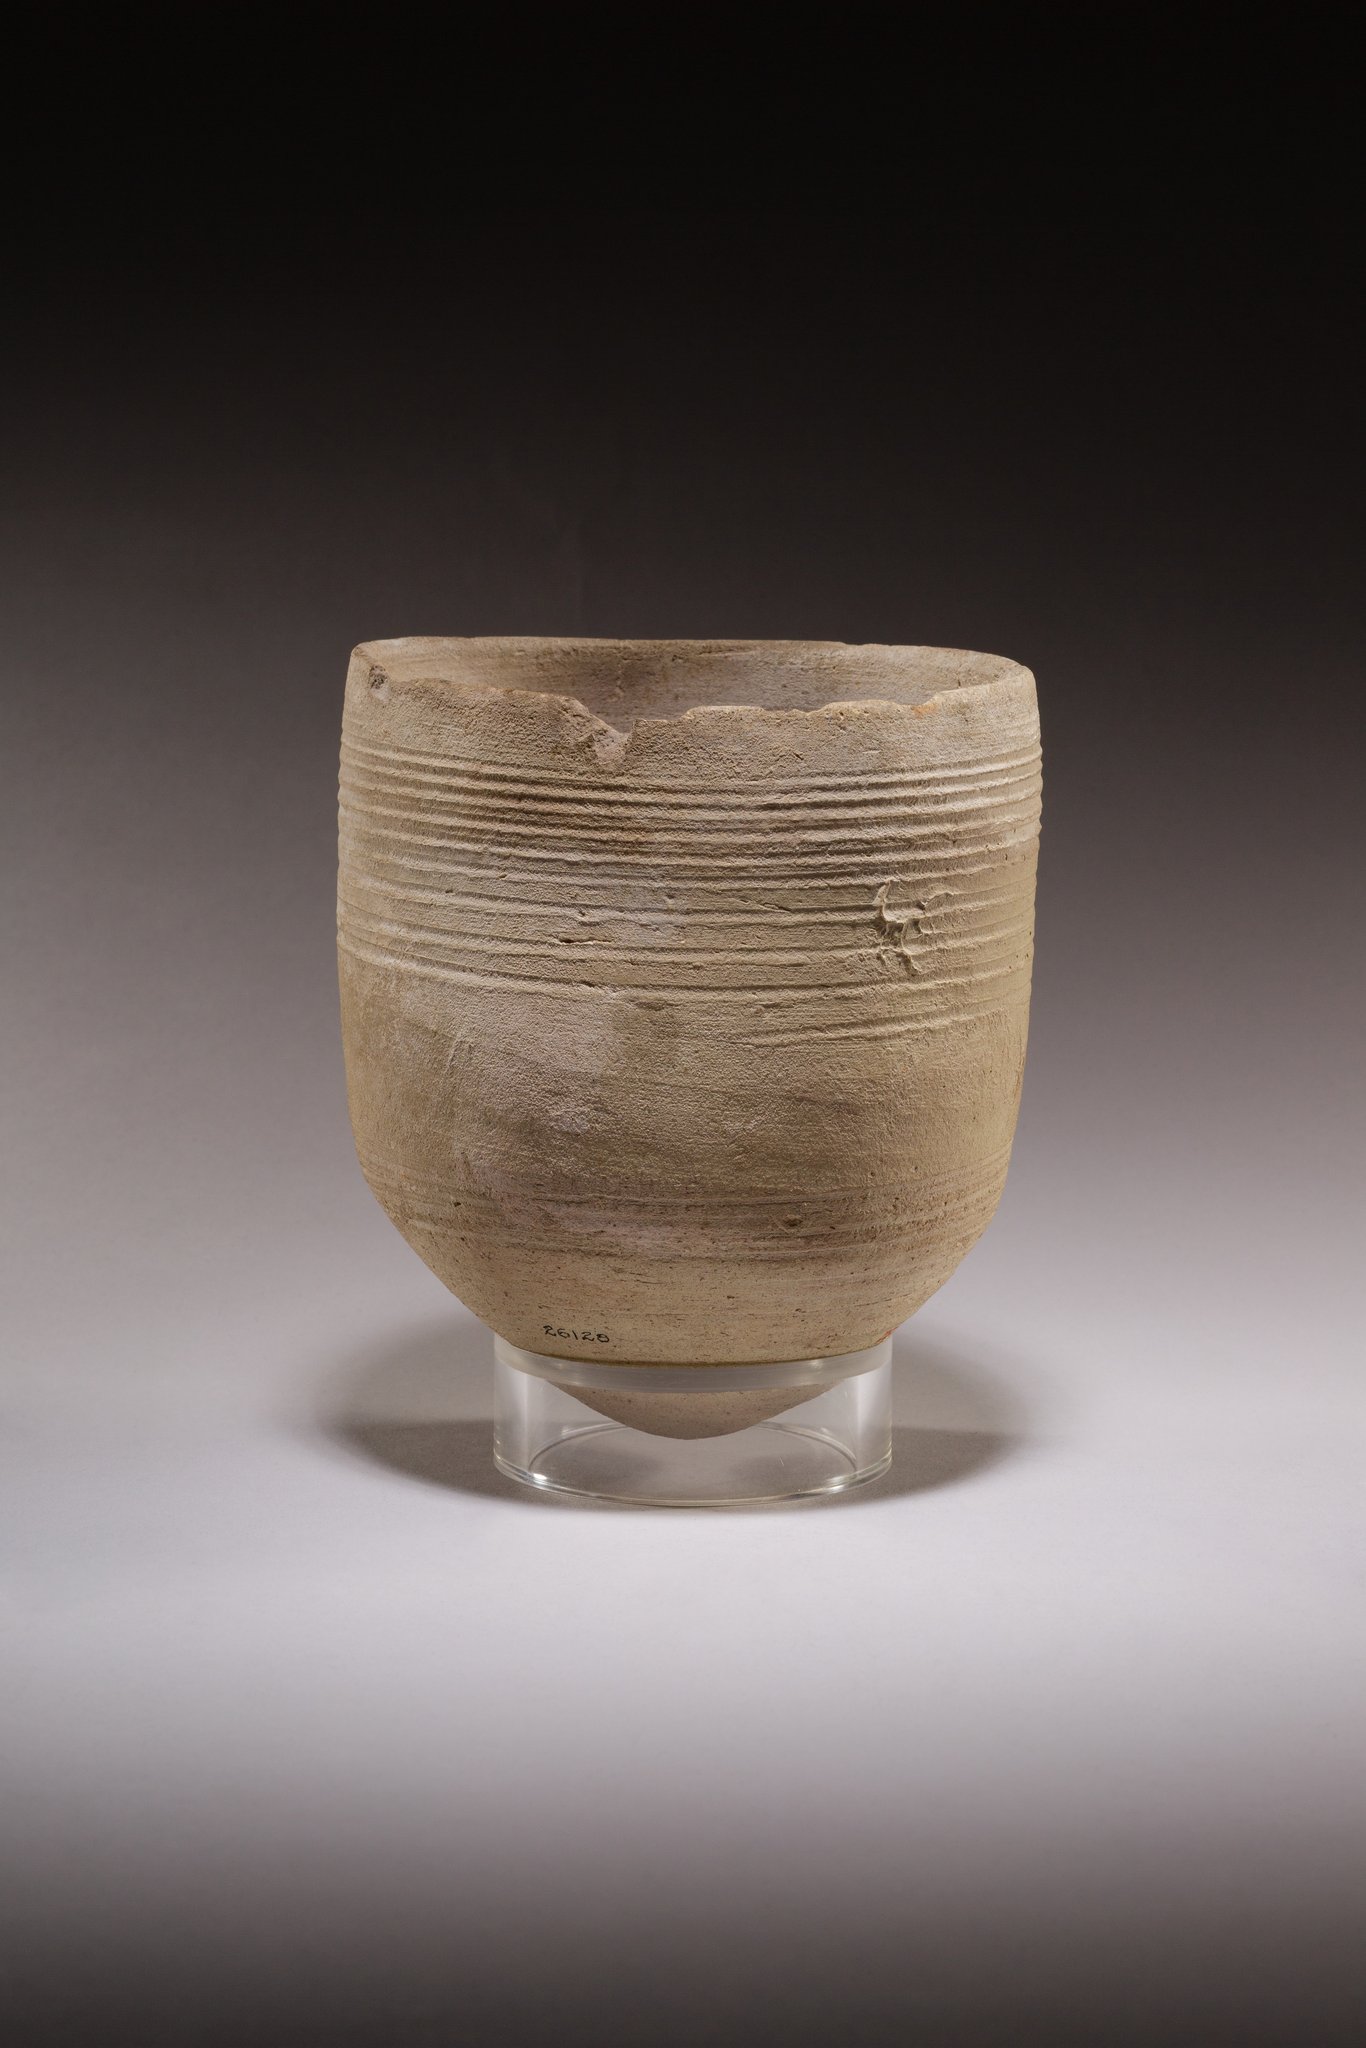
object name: cup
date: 1-200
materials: pottery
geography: egypt